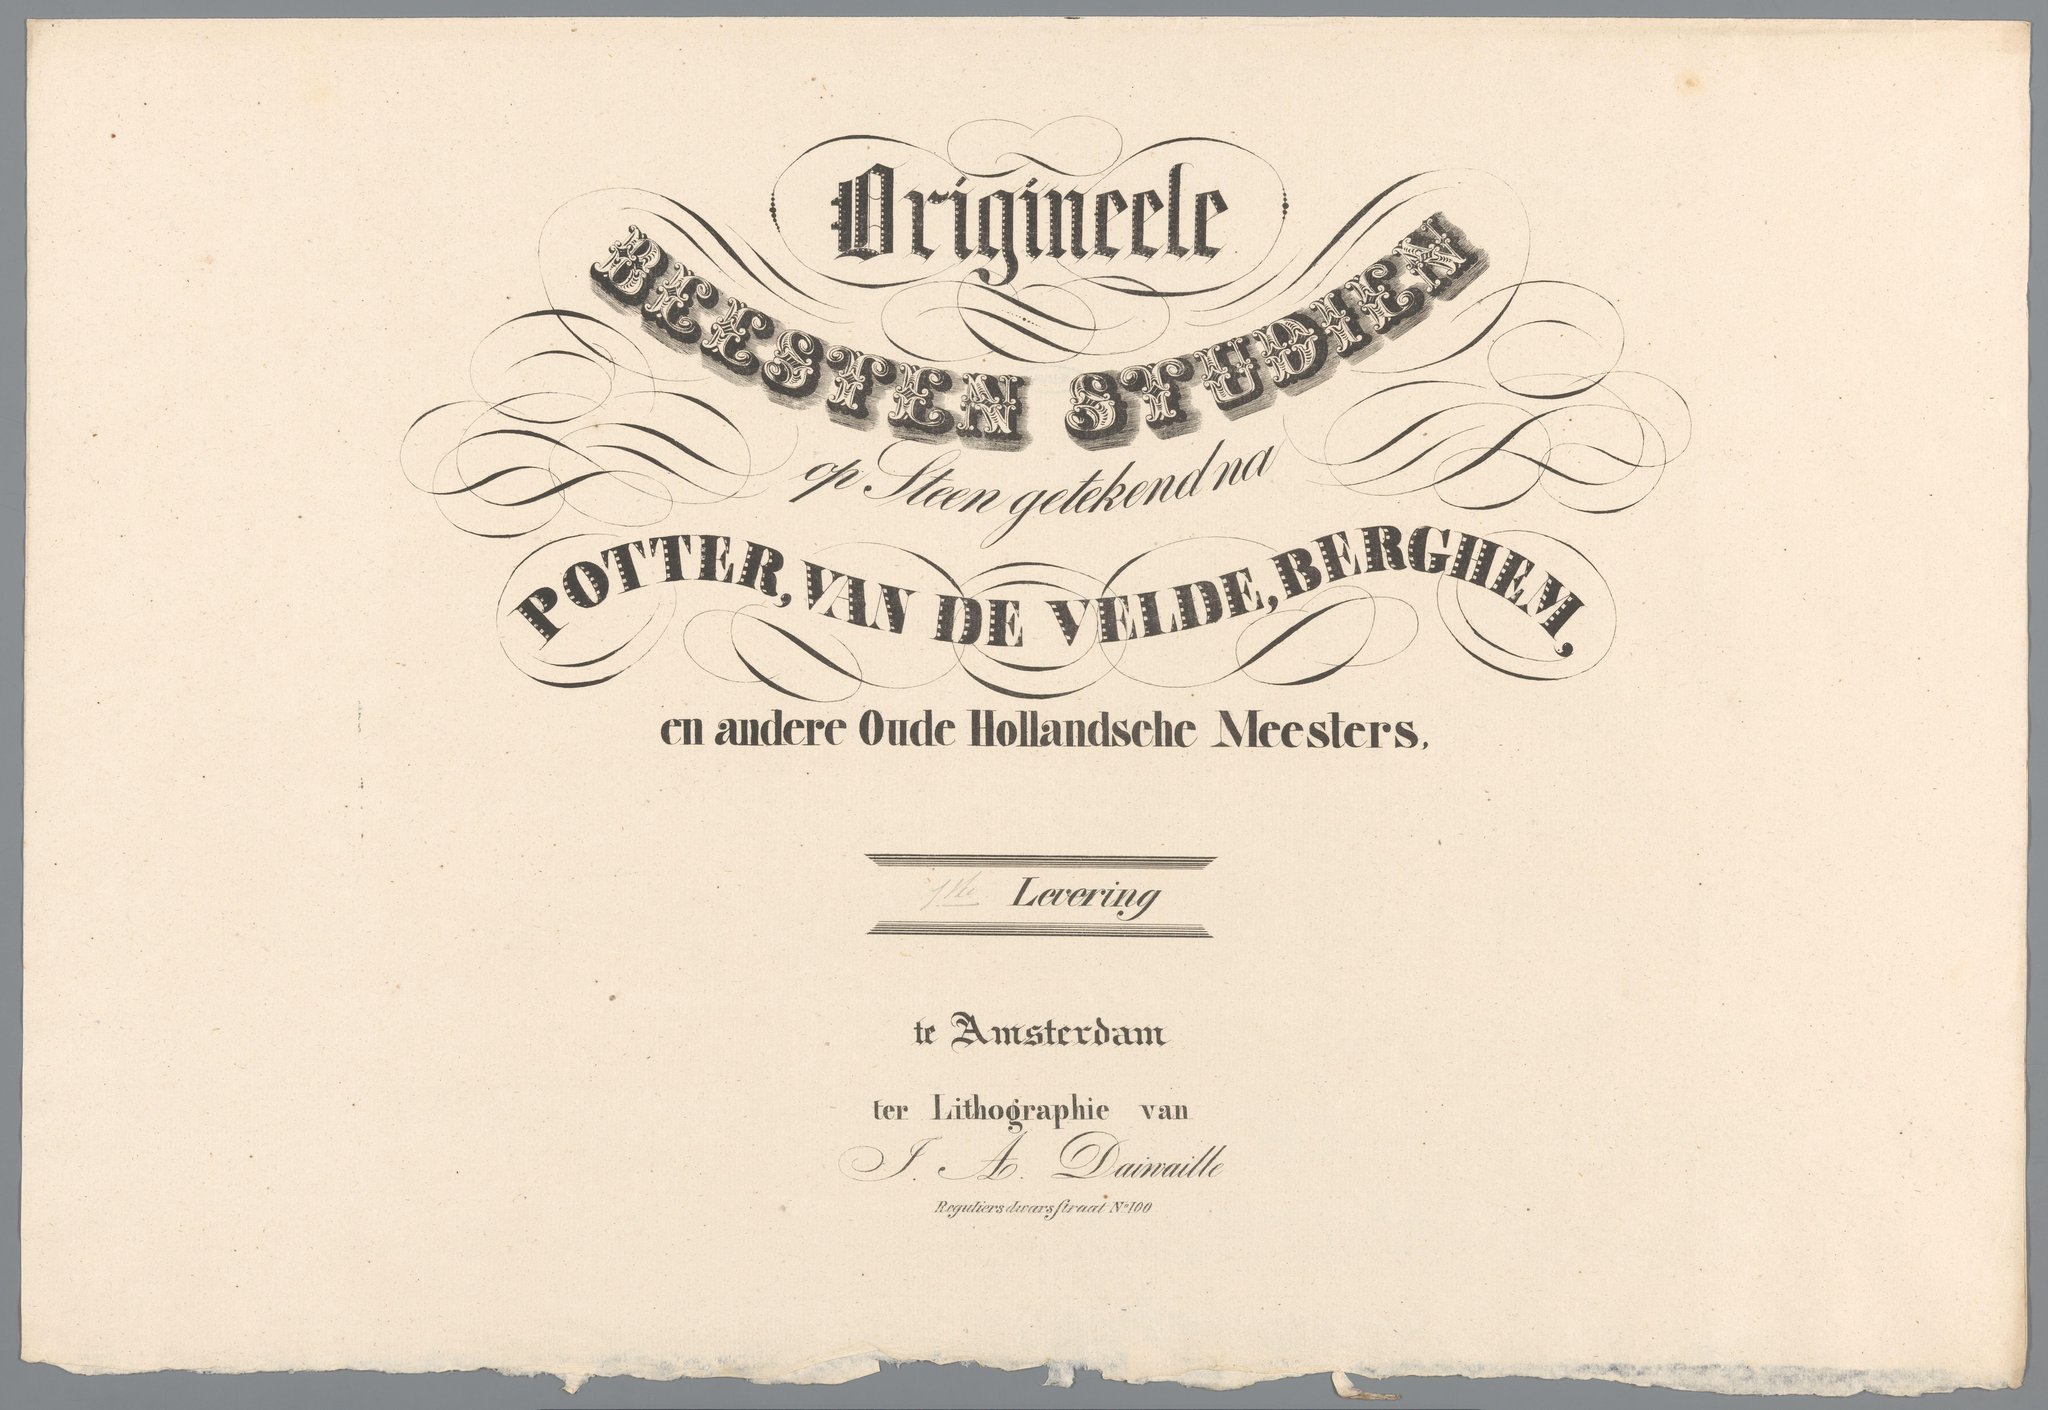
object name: wrapper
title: Omslag voor Origineele Beesten Studien op Steen getekend na Potter, Van de Velde, Berghem, en andere Oude Hollandsche Meesters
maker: jean augustin daiwaille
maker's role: draughtsman, print maker, printer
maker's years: 1786-1850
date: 1820-1833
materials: paper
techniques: lithograph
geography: amsterdam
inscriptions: inscription: ‘1ste’, collector's mark: Lugt 2228